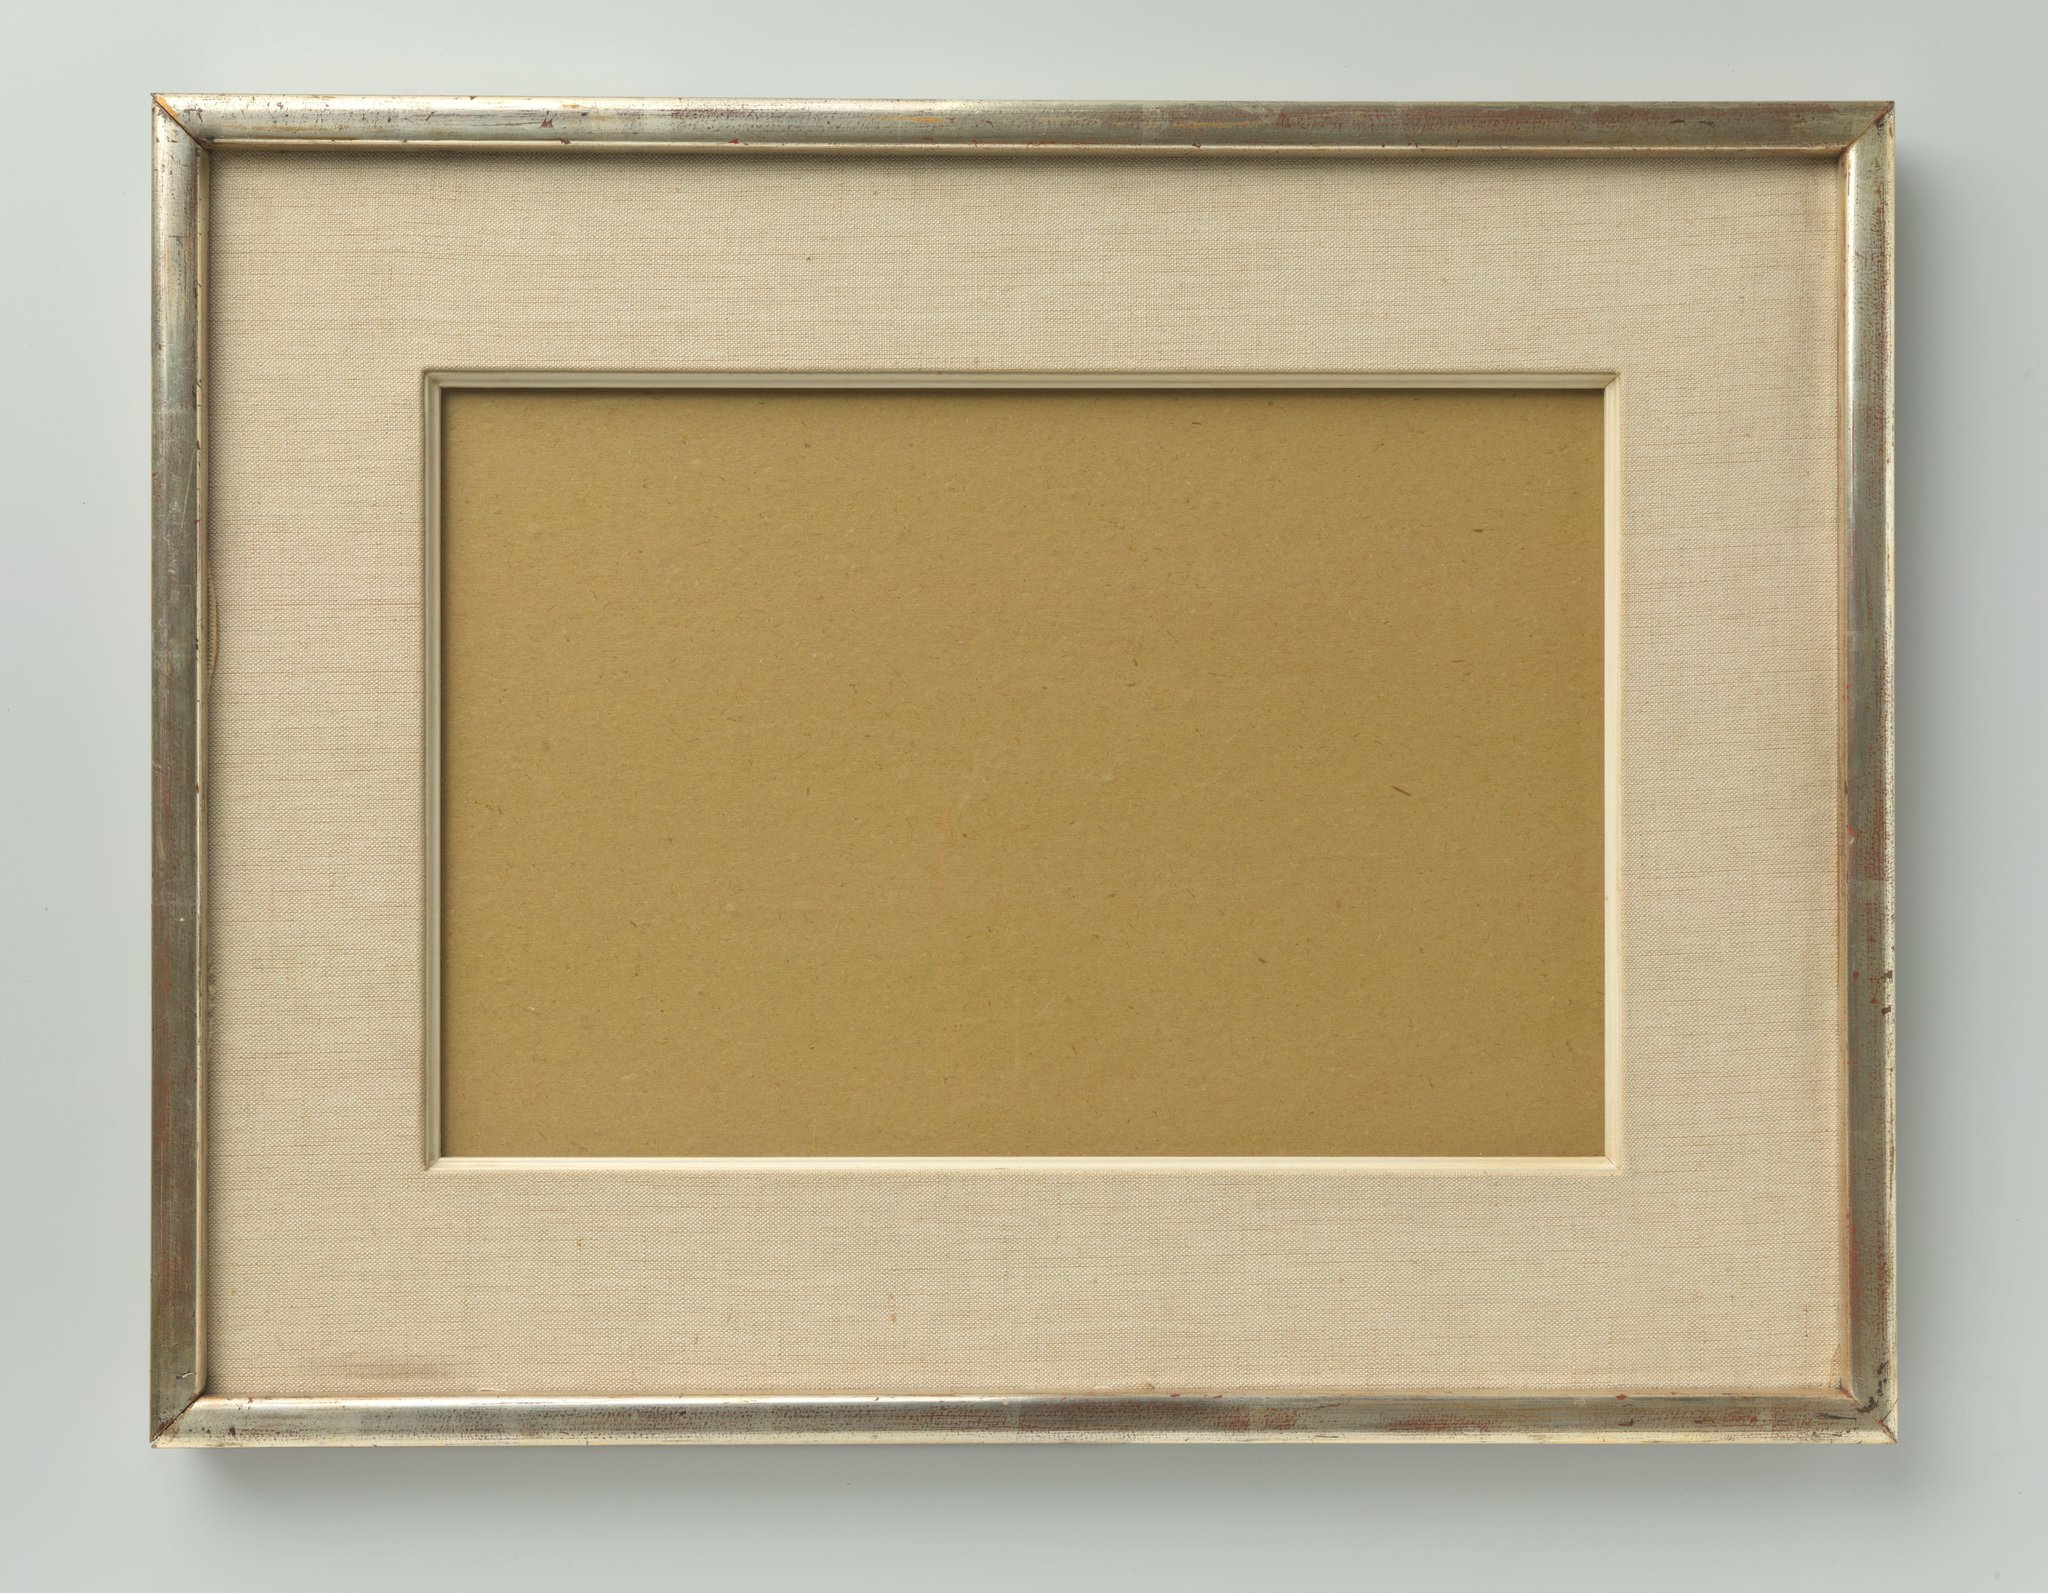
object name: frame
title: Lijst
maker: Anonymous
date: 1400-1950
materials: cardboard, wood